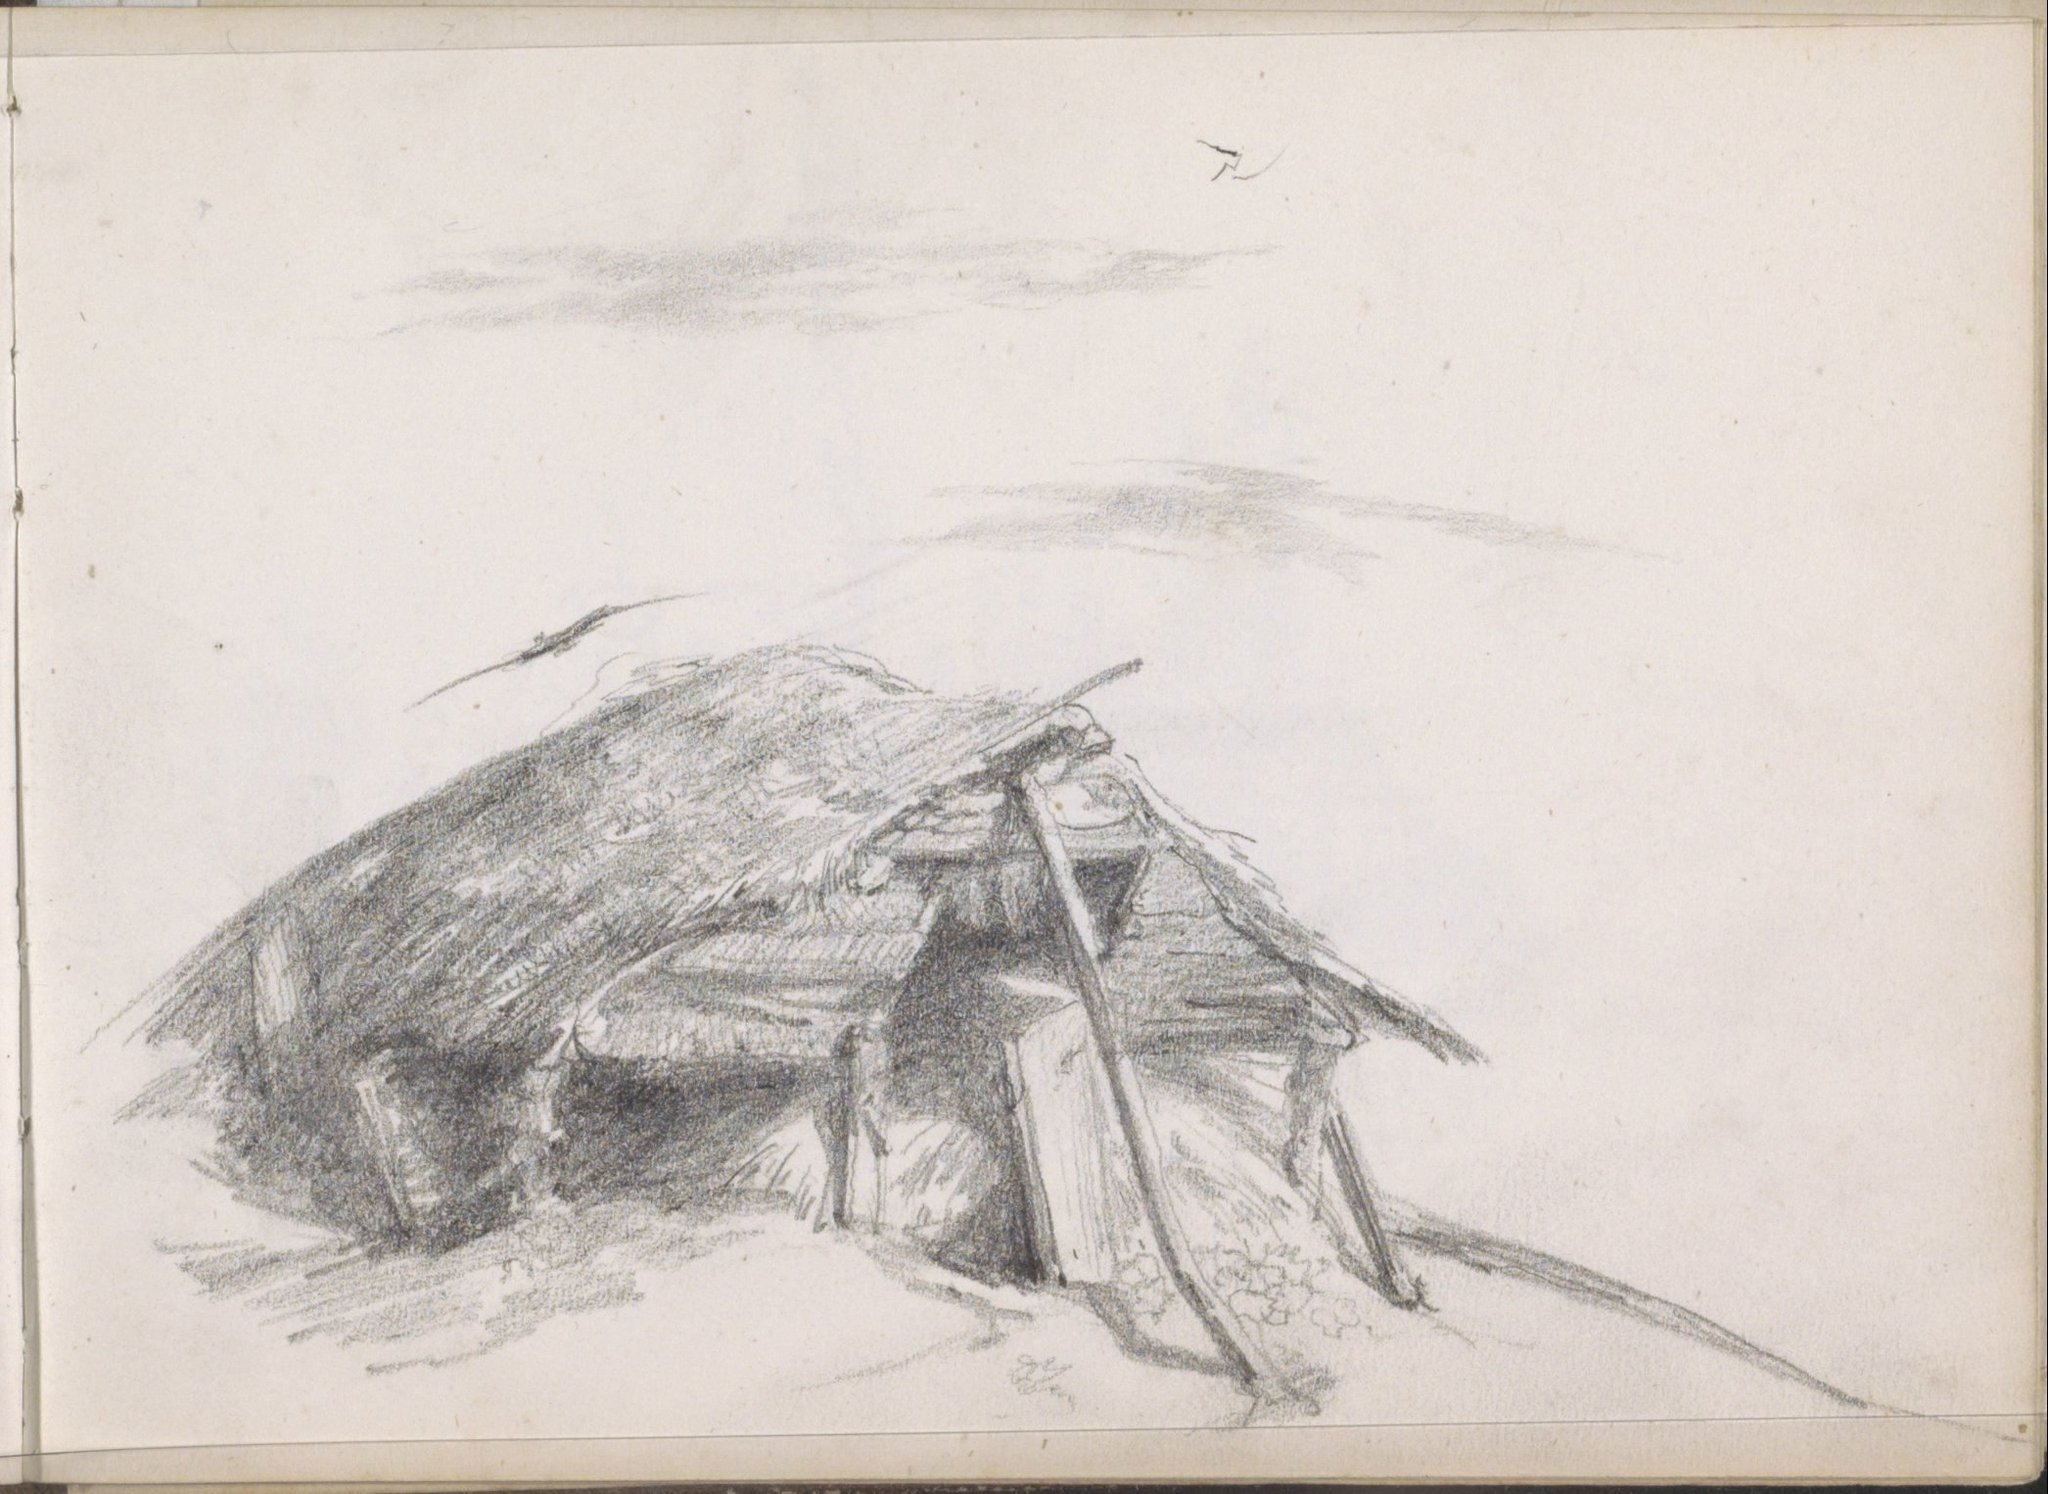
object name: sketchbook leaf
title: Plaggenhut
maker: maria vos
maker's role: draughtsman, painter, print maker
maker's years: 1824-1906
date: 1834-1906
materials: paper, pencil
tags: hut, cabin, lodge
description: Blad 22 recto uit een schetsboek met 30 bladen.